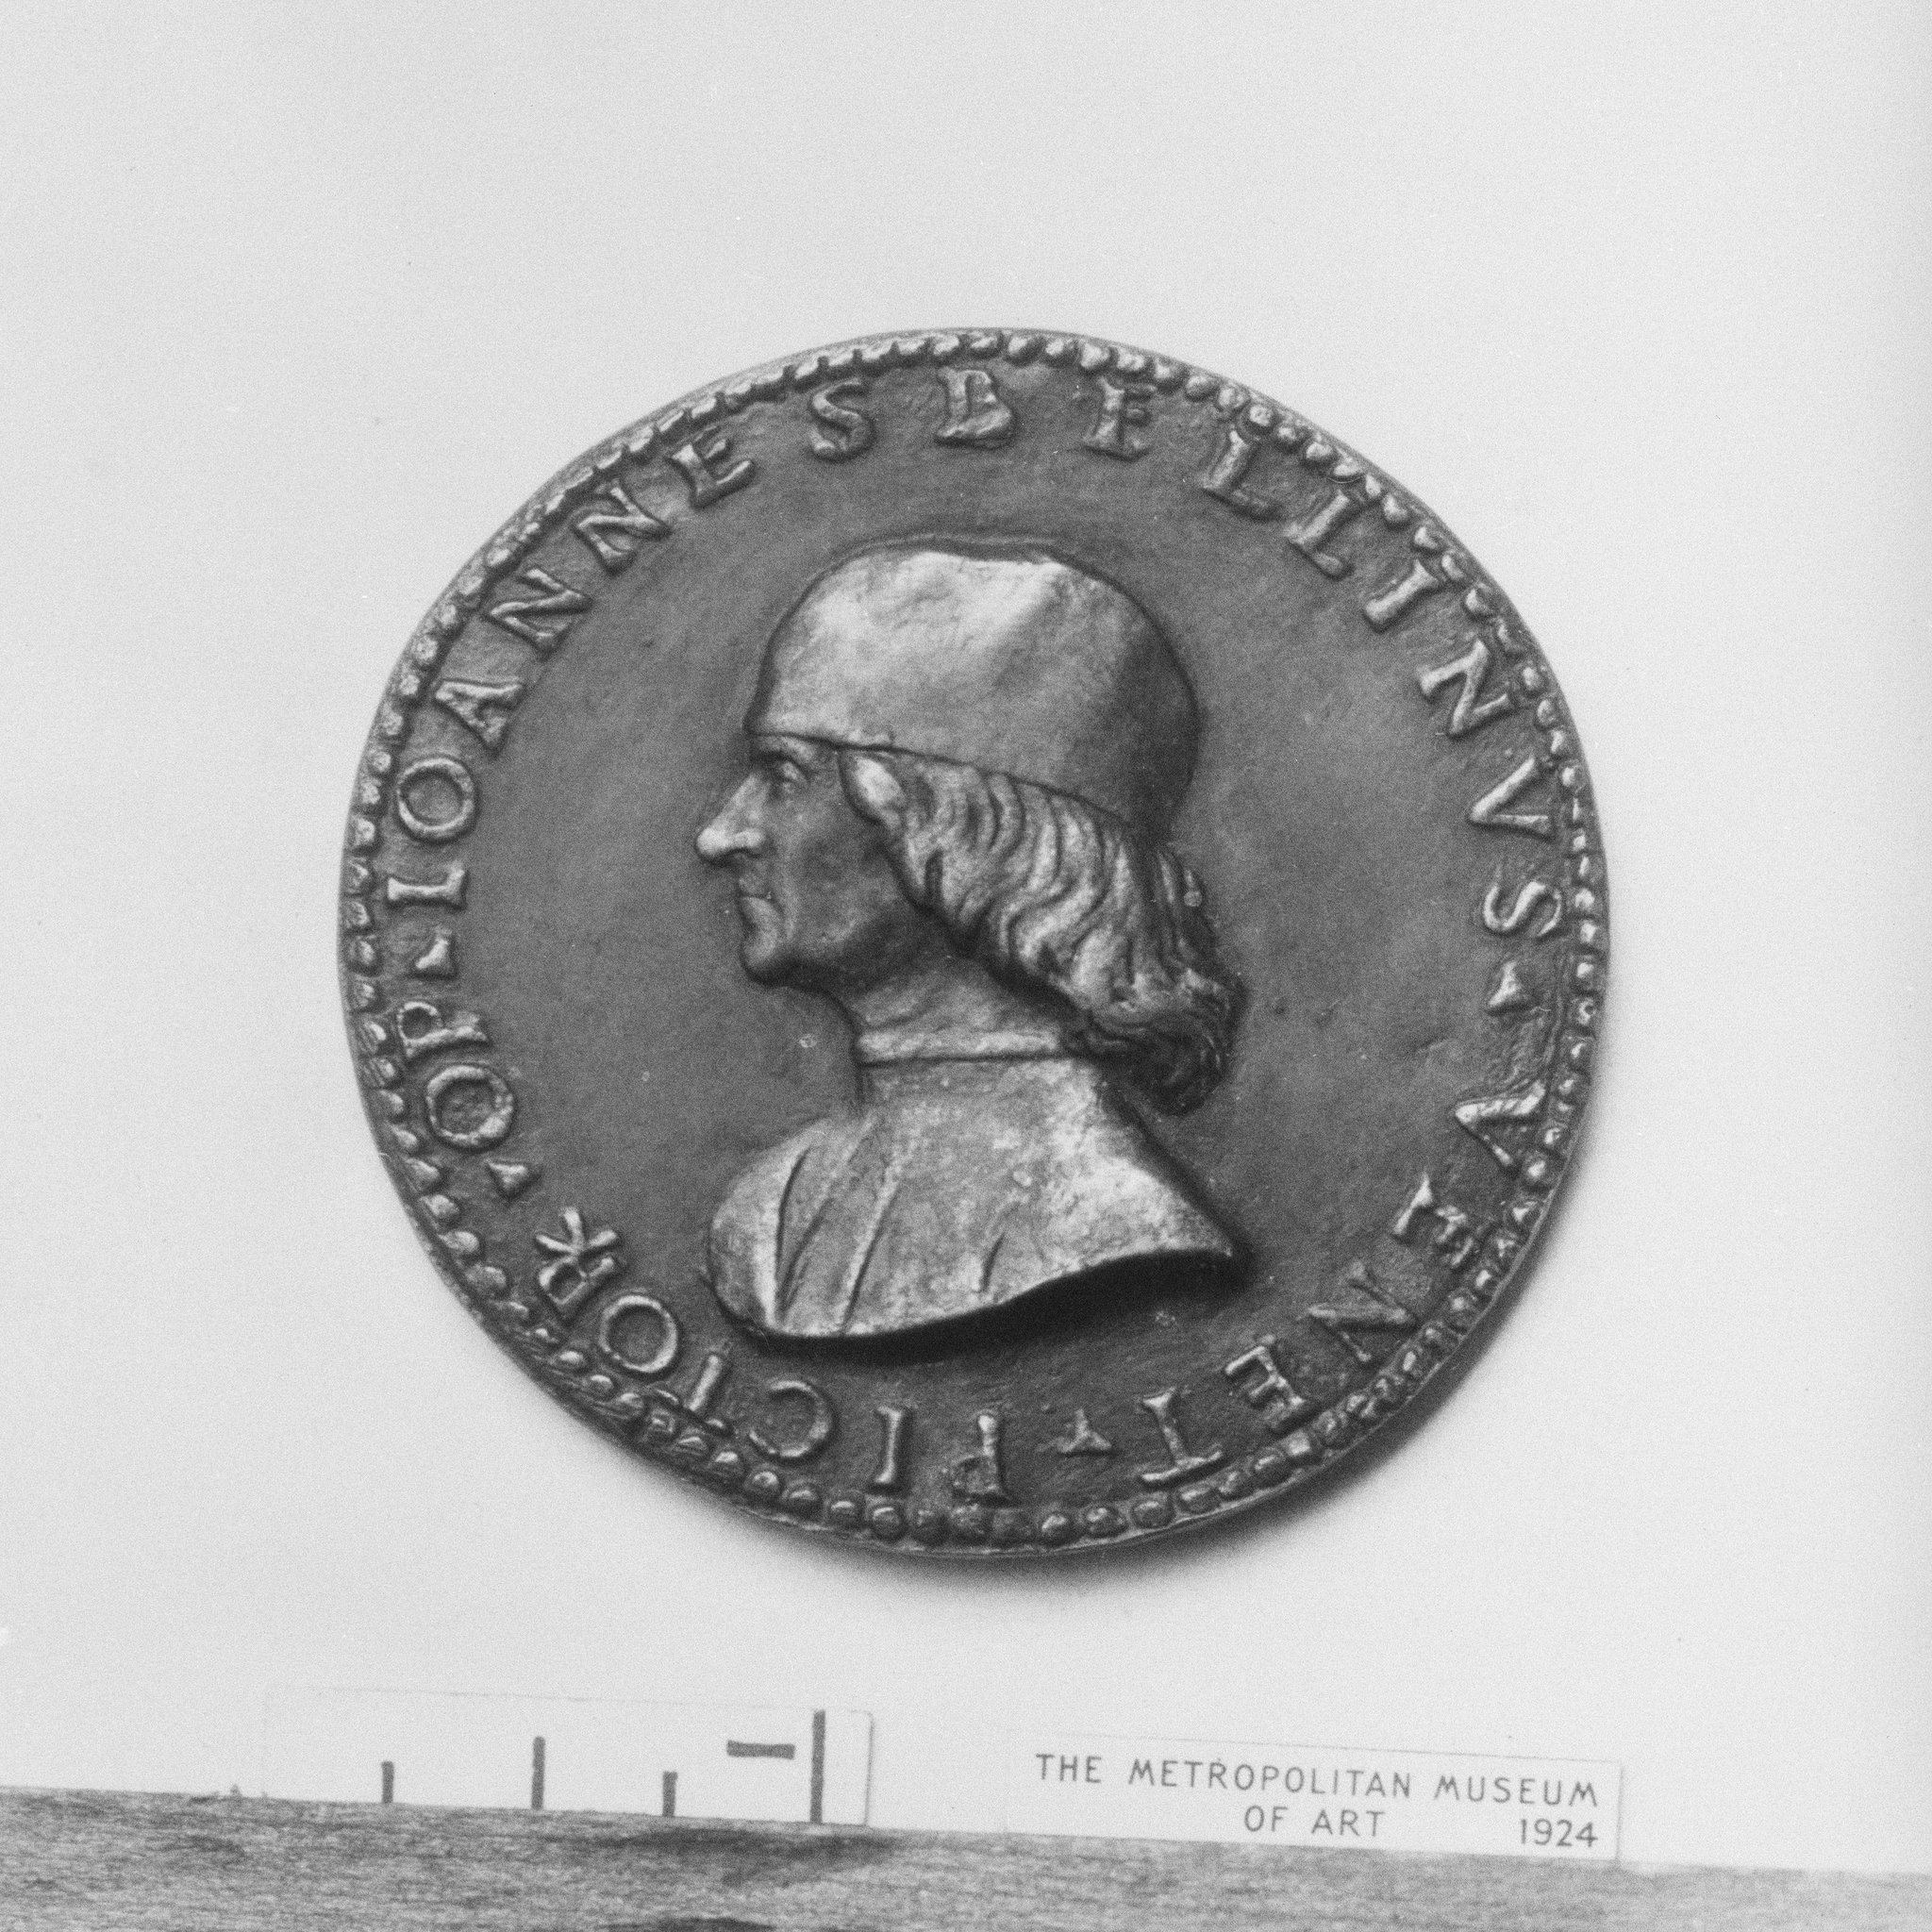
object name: medal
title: Giovanni Bellini, Venetian painter (ca. 1430–1516)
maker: vittore gambello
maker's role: artist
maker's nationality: italian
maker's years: 1455-1537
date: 1500-1510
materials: bronze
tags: birds,men,profiles